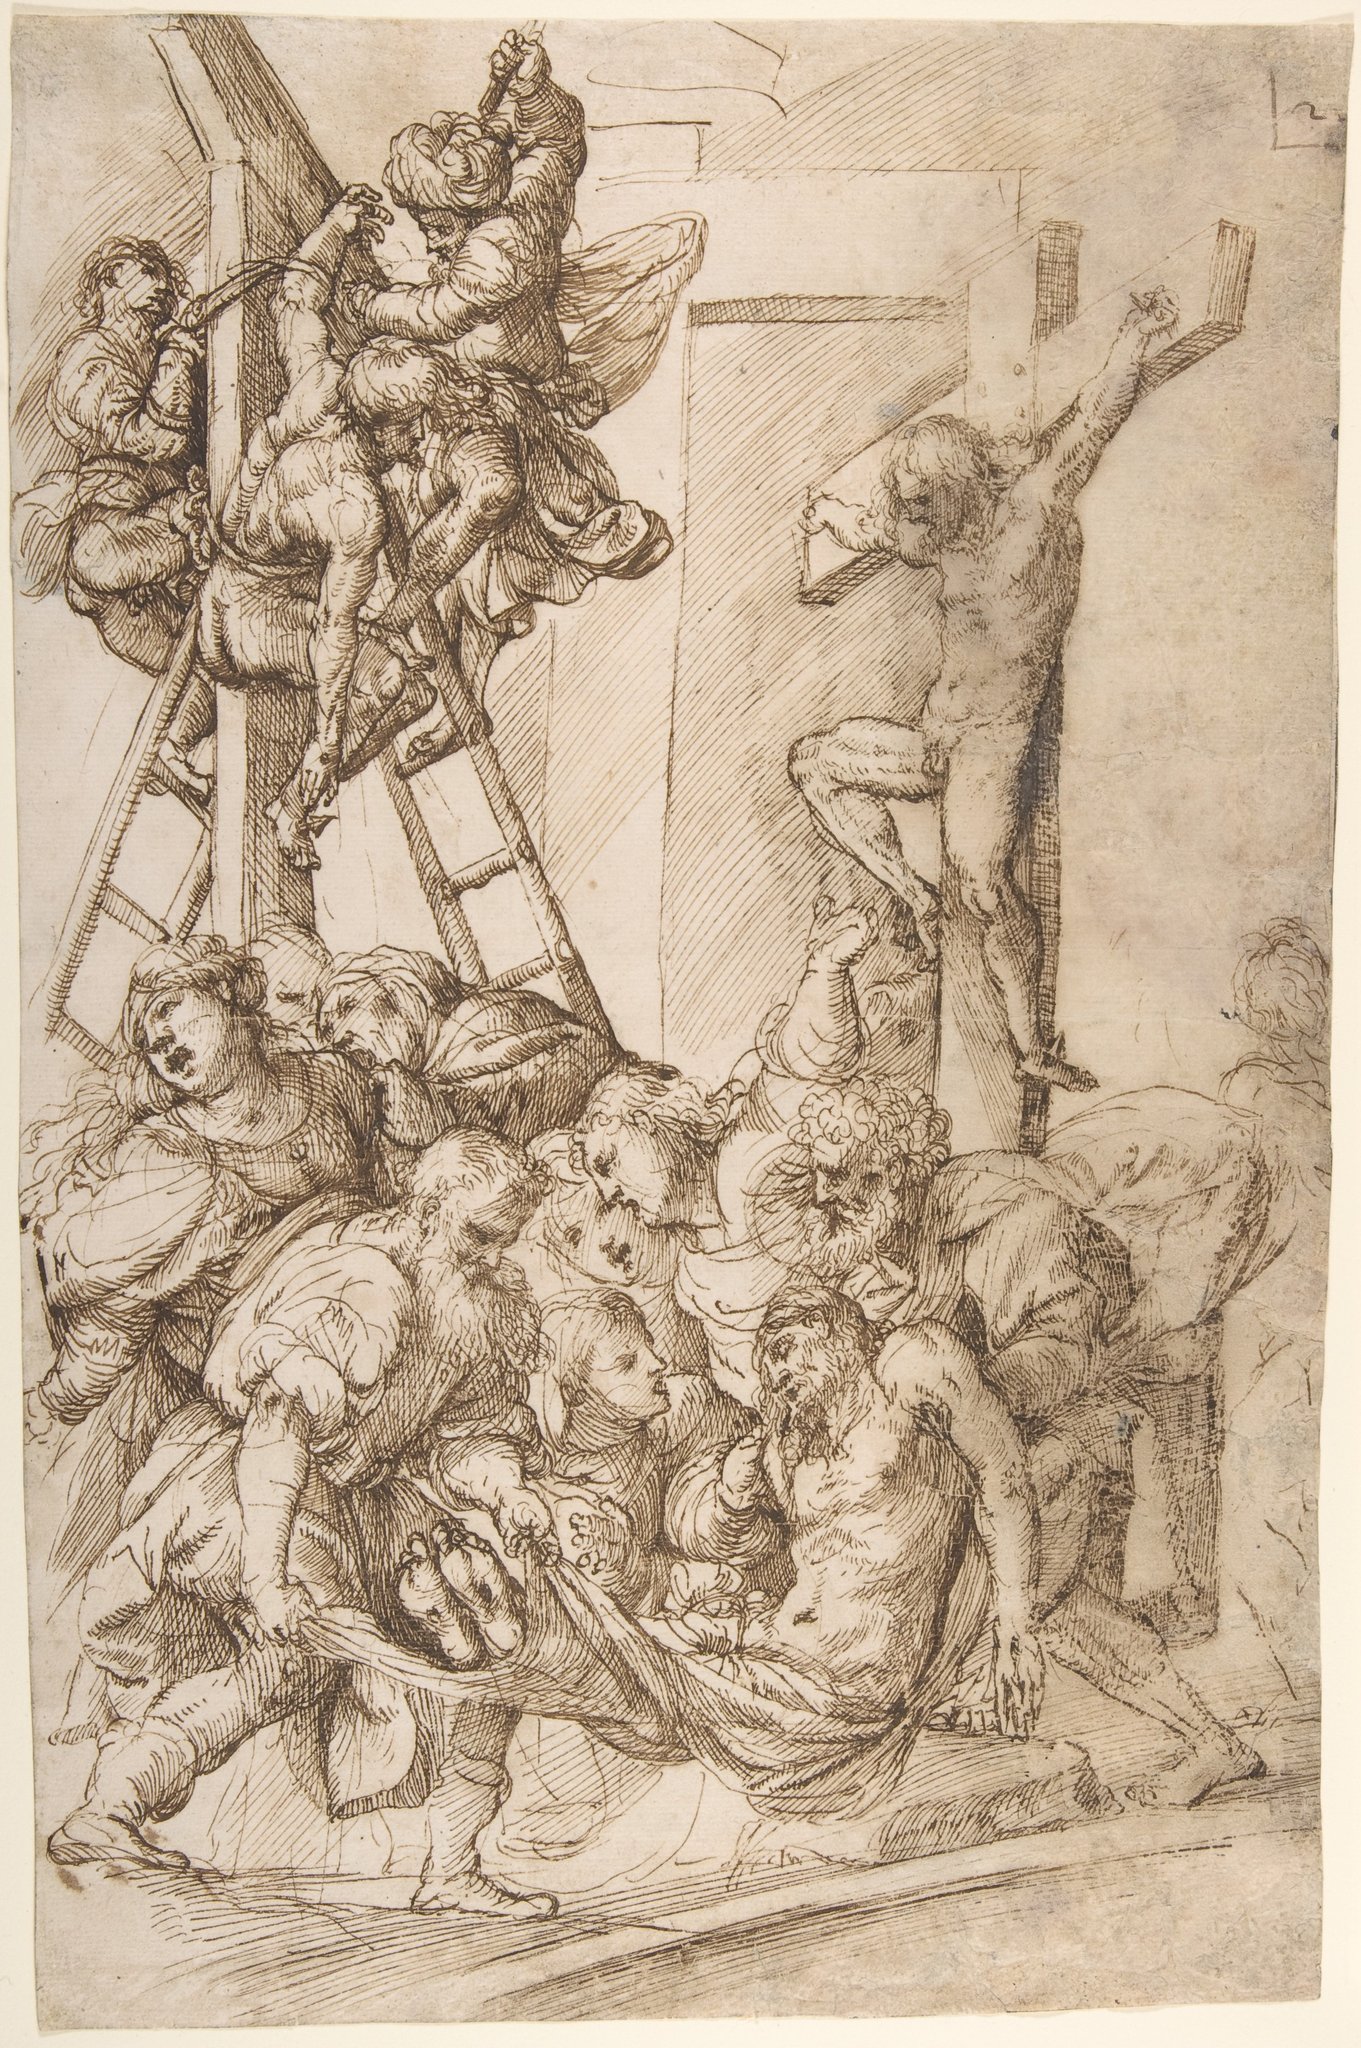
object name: drawing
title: The Deposition from the Cross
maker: domenico campagnola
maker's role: artist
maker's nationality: italian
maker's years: 1500-1564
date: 1537-1550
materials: ink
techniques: pen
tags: men,christ,cross,crucifixion,ladders